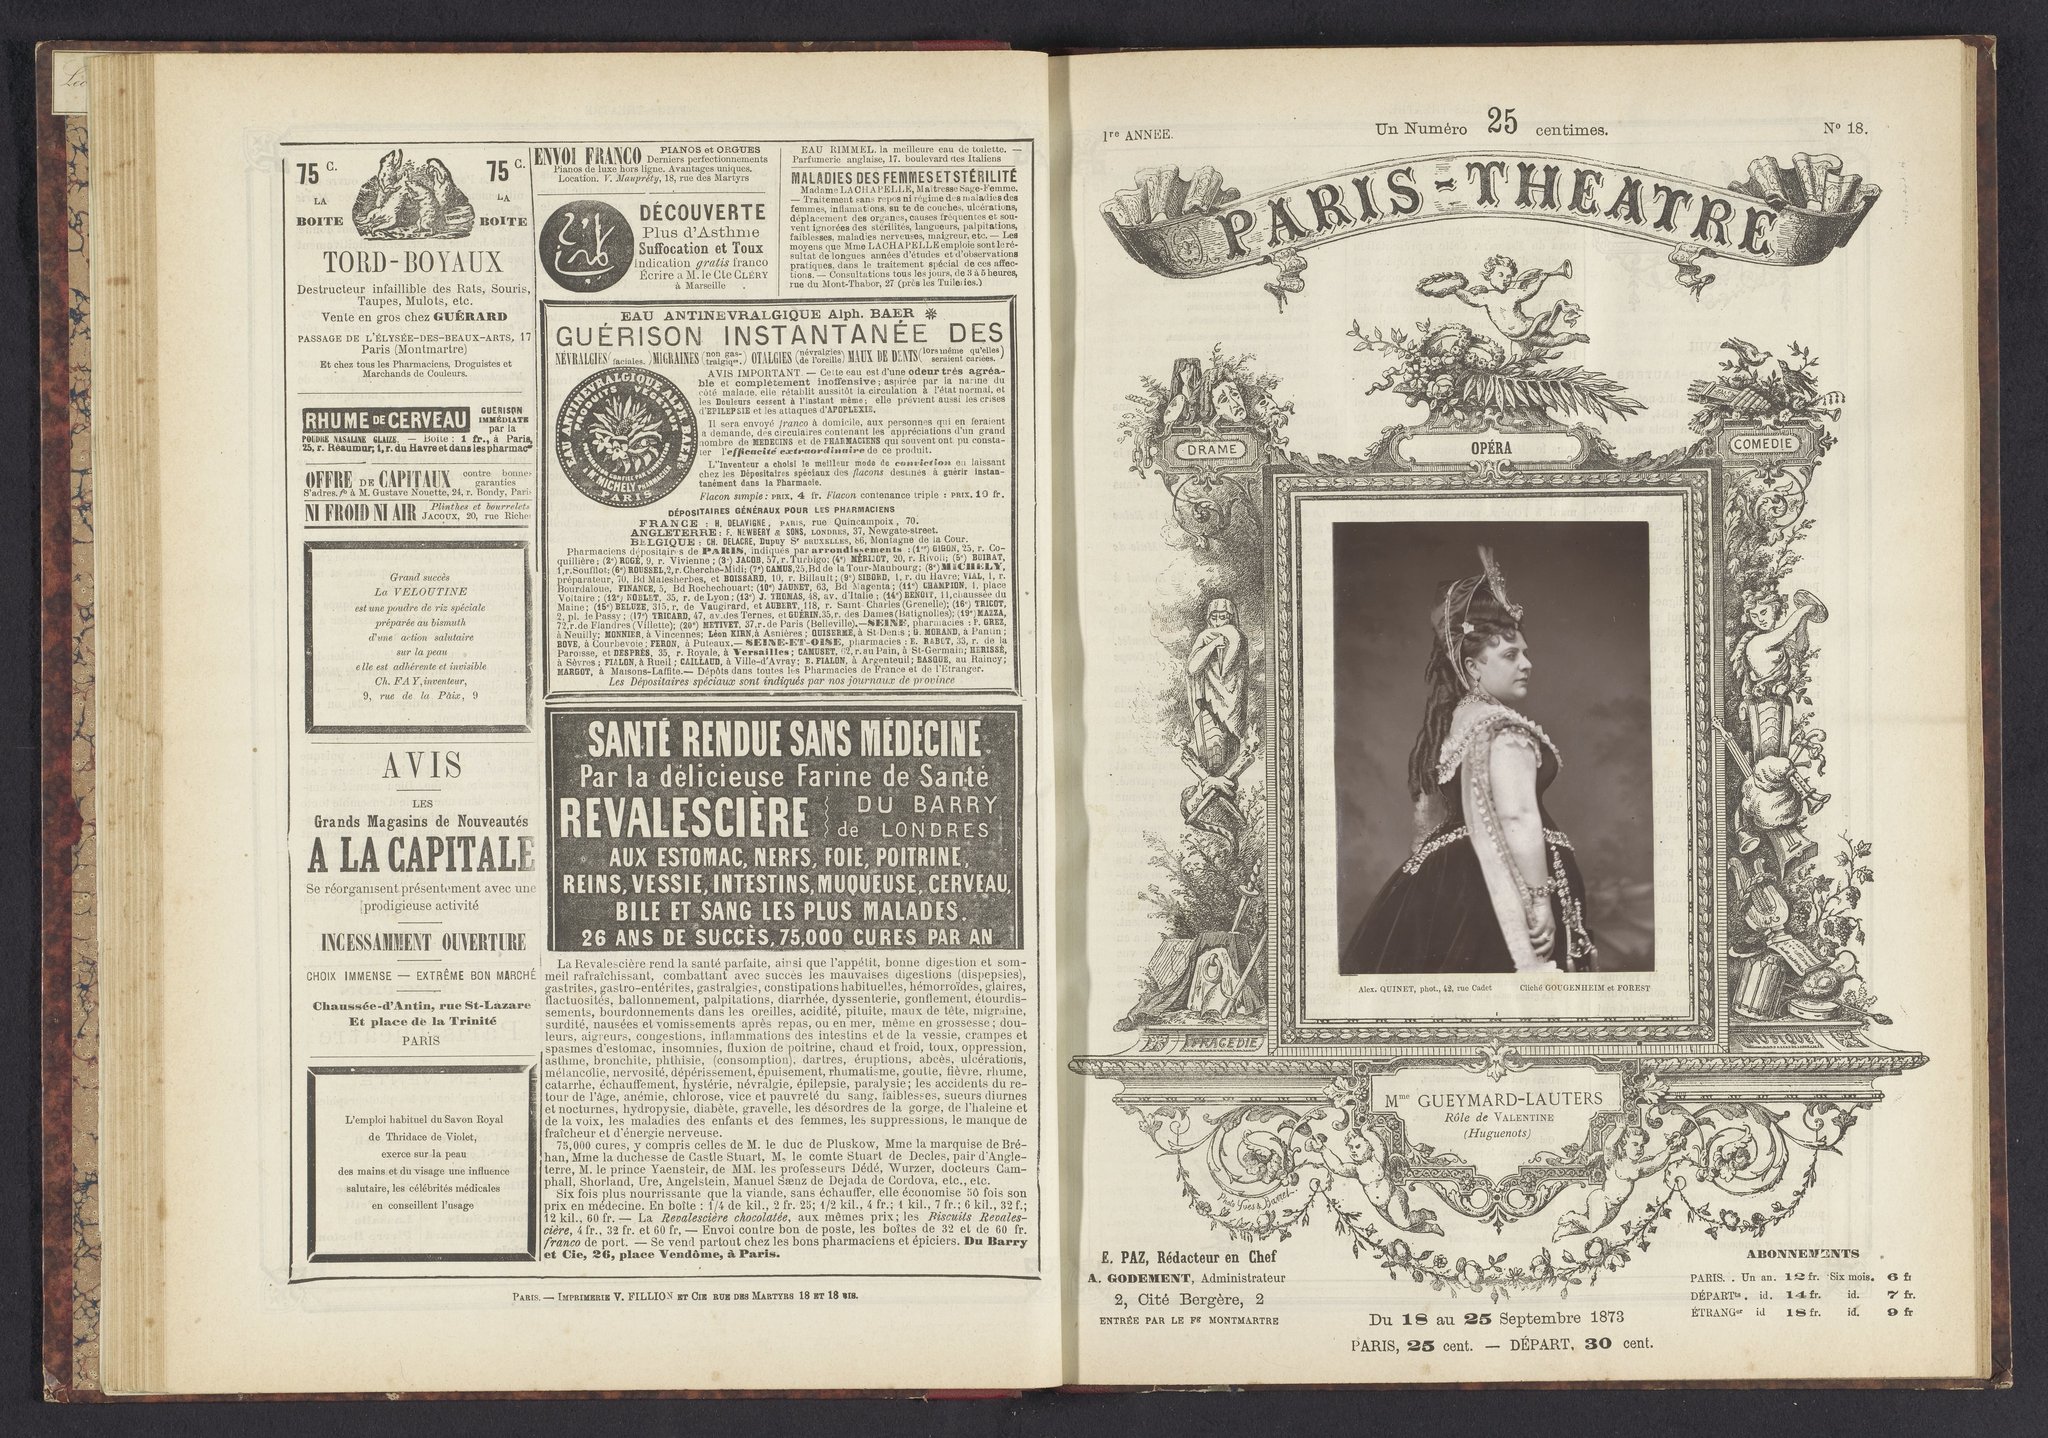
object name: page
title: Portret van Pauline Gueymard-Lauters als Valentine in Les Huguenots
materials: paper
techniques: woodburytype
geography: france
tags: portrait of opera-singer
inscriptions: inscription: ‘Du 18 au 25 Septembre 1873’, number: ‘No 18.’